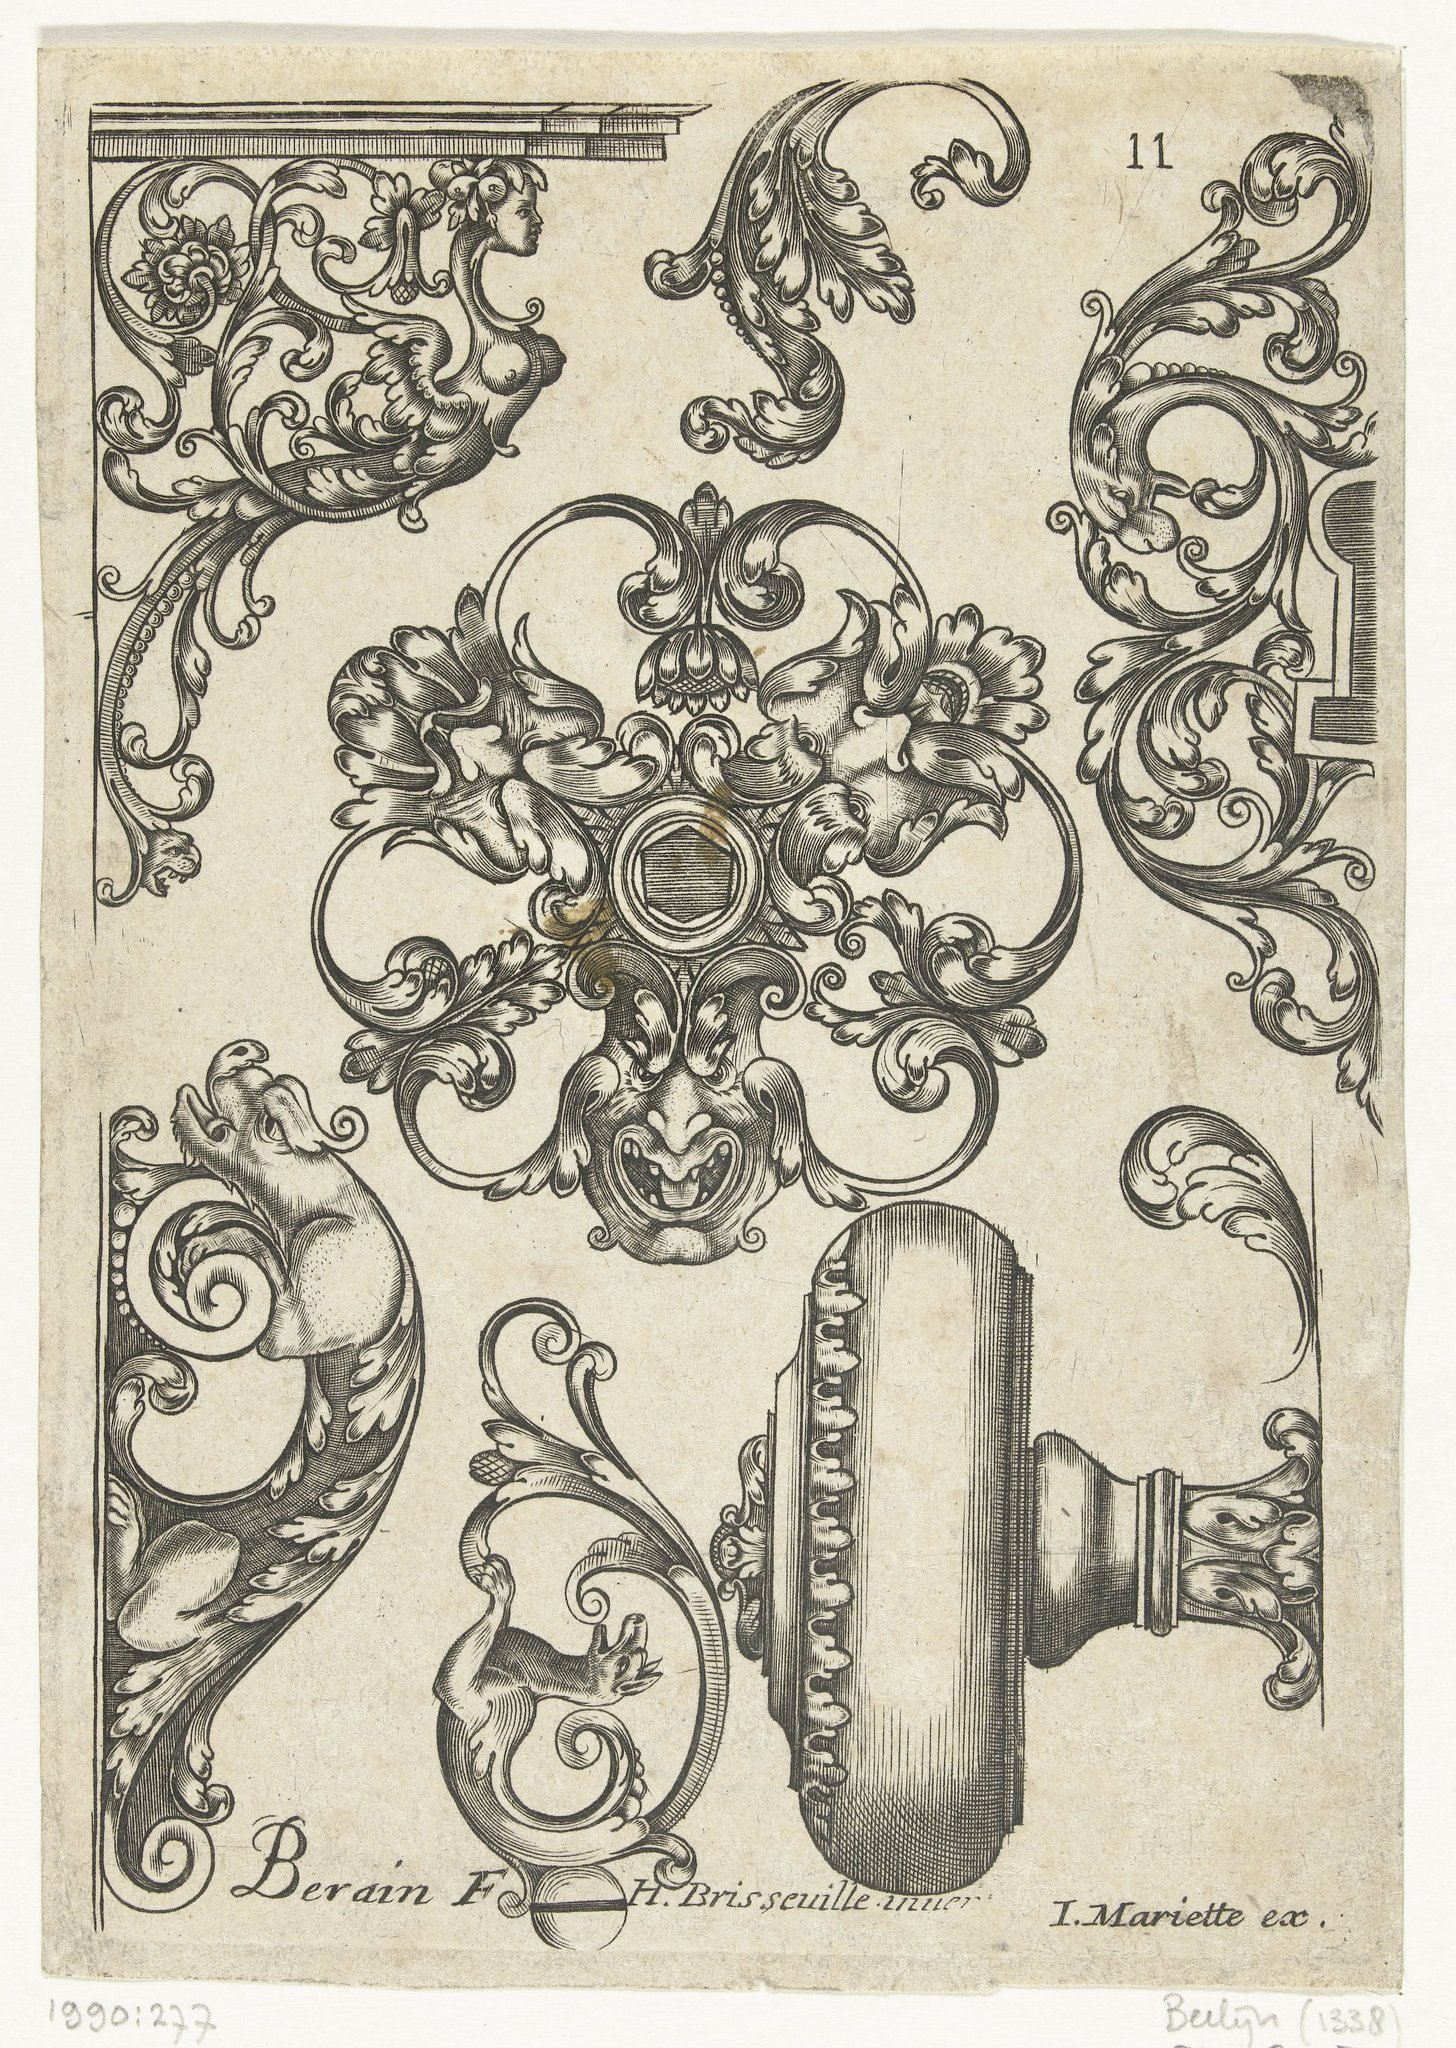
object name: ornament print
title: Ontwerpen voor console van de zijkant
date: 1710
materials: paper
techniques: engraving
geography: france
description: Linksboven staat een bladmotief afgebeeld, rechtsboven het beslag voor rond een sleutelgat, in het midden een rozet rond een vijfhoekig gat, mogelijk voor een deurknop. Linksonder is een deurklopper van opzij weergegeven, en rechtsonder een deurknop. Blad 11 uit serie met beslag, sleutelgatplaten, smeedwerk, sleutels, deurkloppers en deurknoppen. Derde editie.